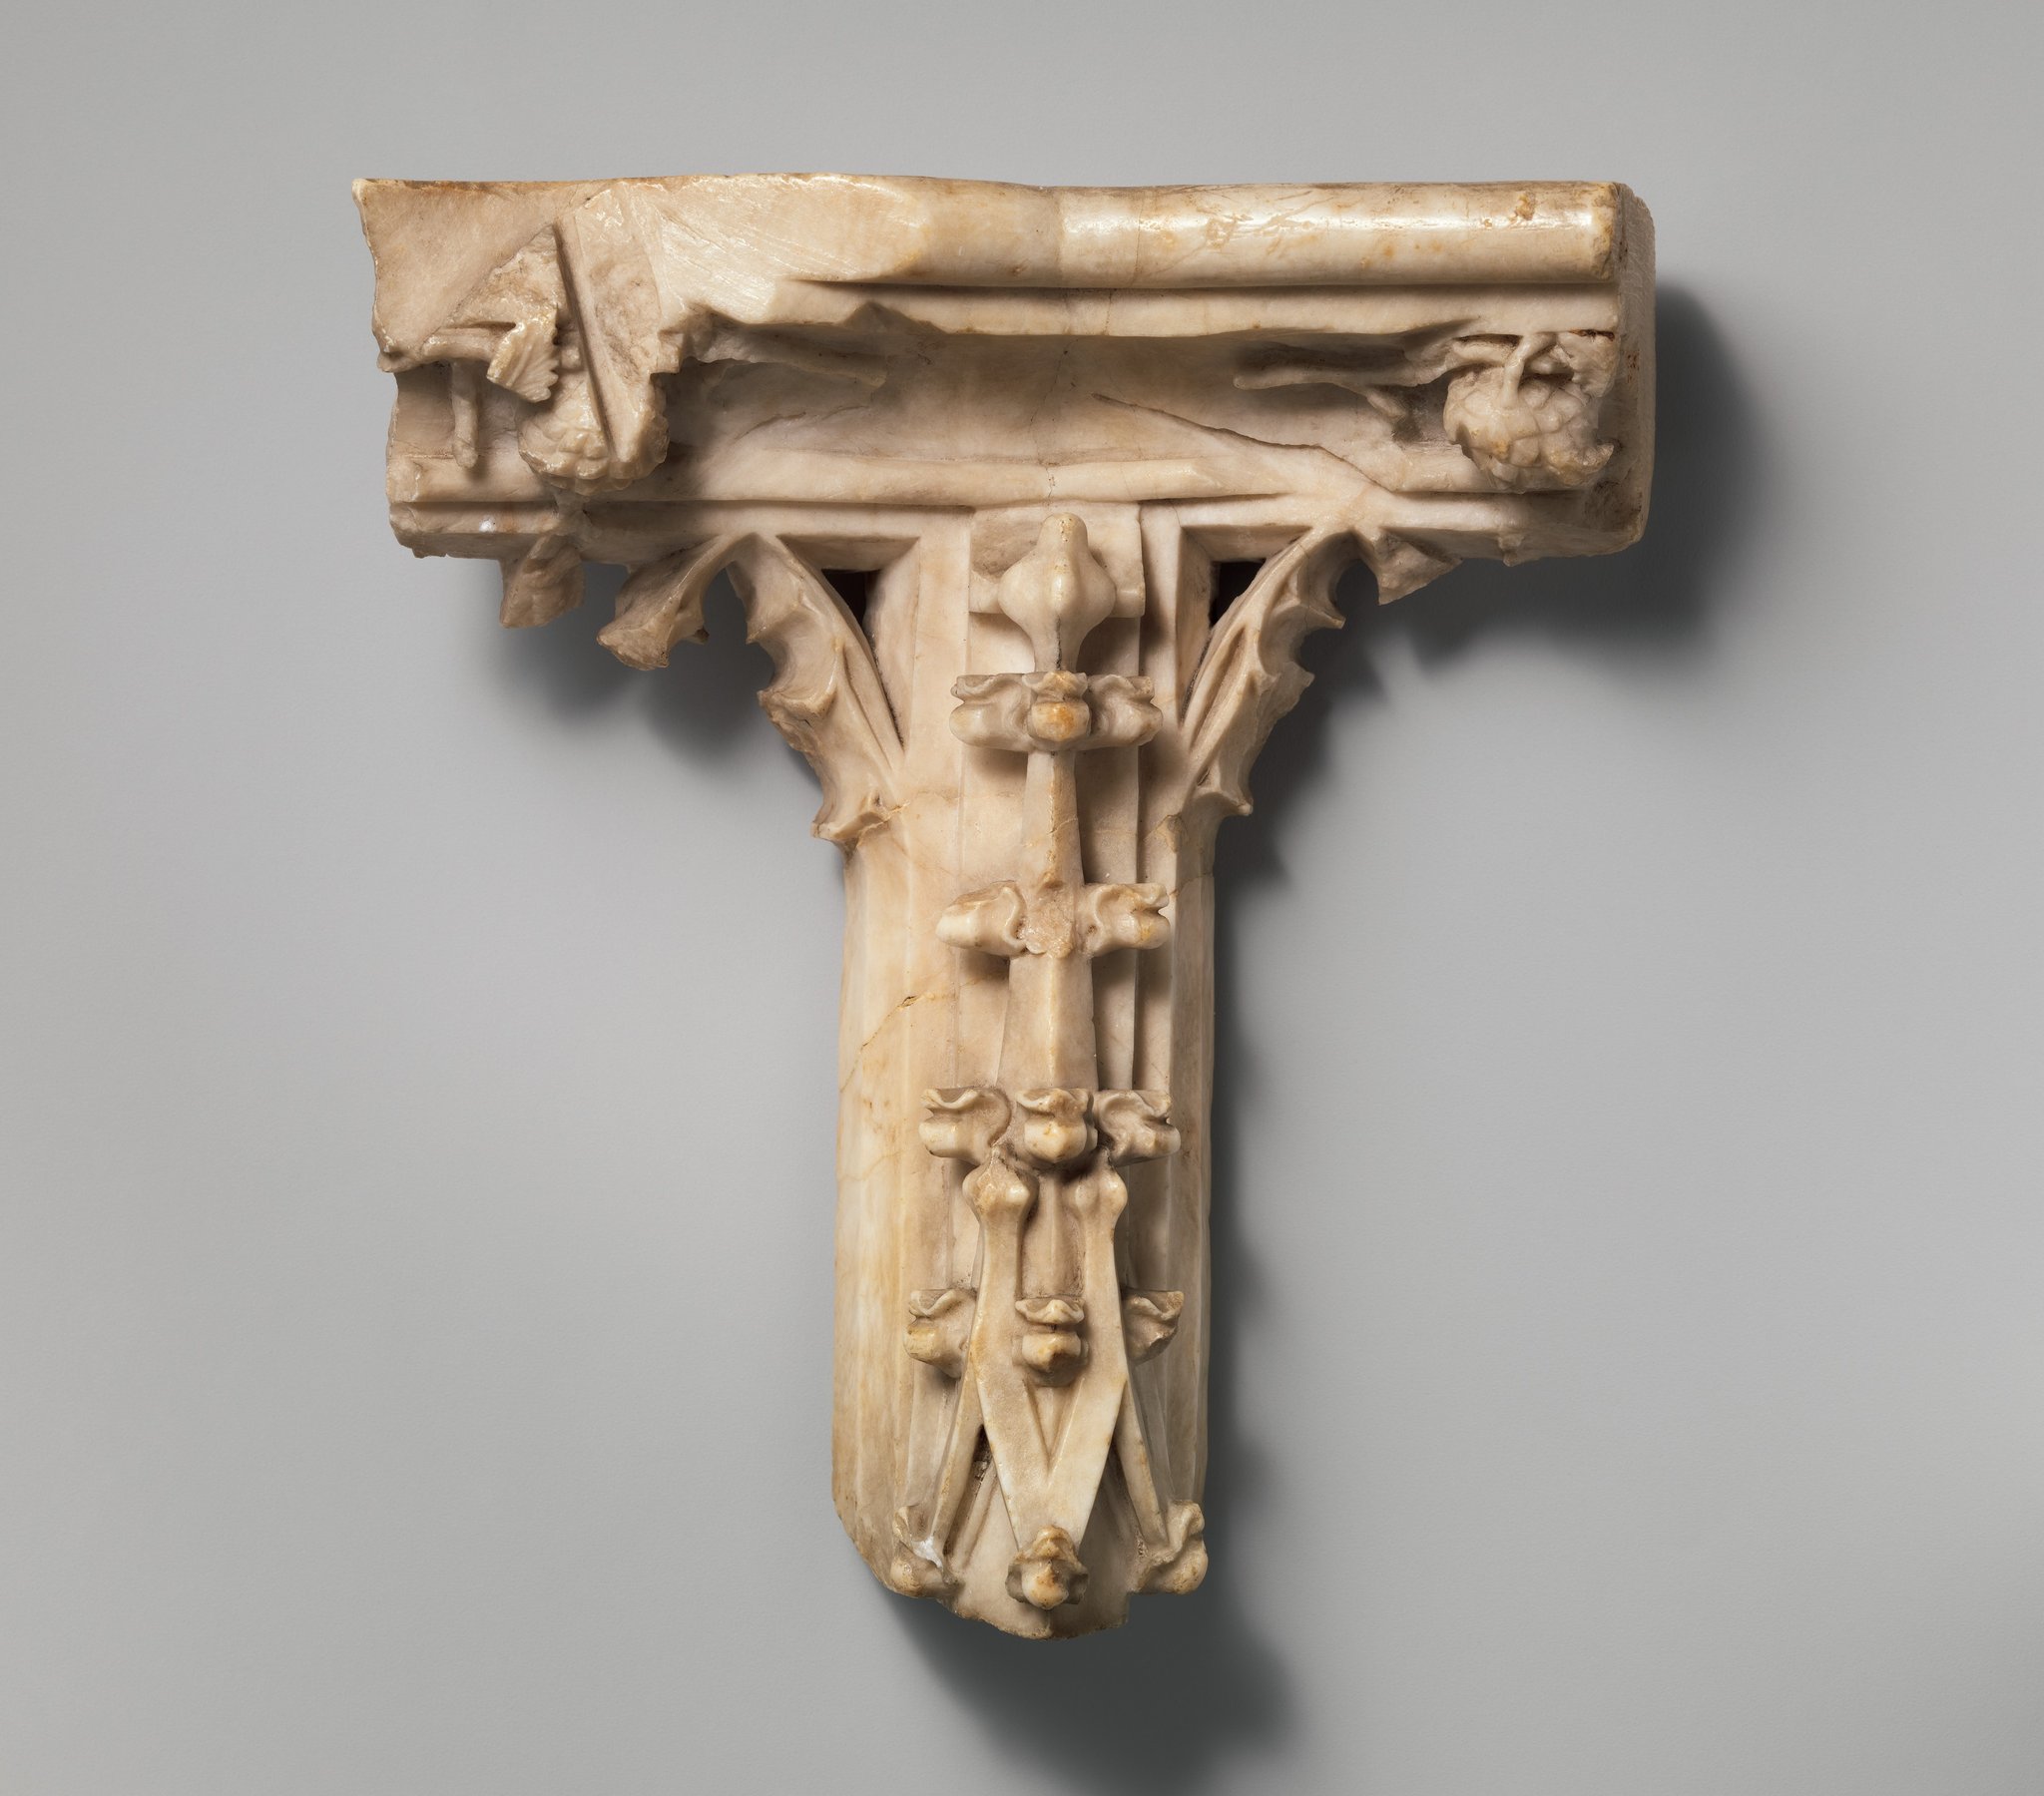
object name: tomb fragment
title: Fragment from the Tomb of John the Fearless and Margaret of Bavaria, Duke and Duchess of Burgundy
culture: french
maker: jean de la huerta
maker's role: artist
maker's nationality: spanish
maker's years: 1413-1462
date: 1443-1455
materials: alabaster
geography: france